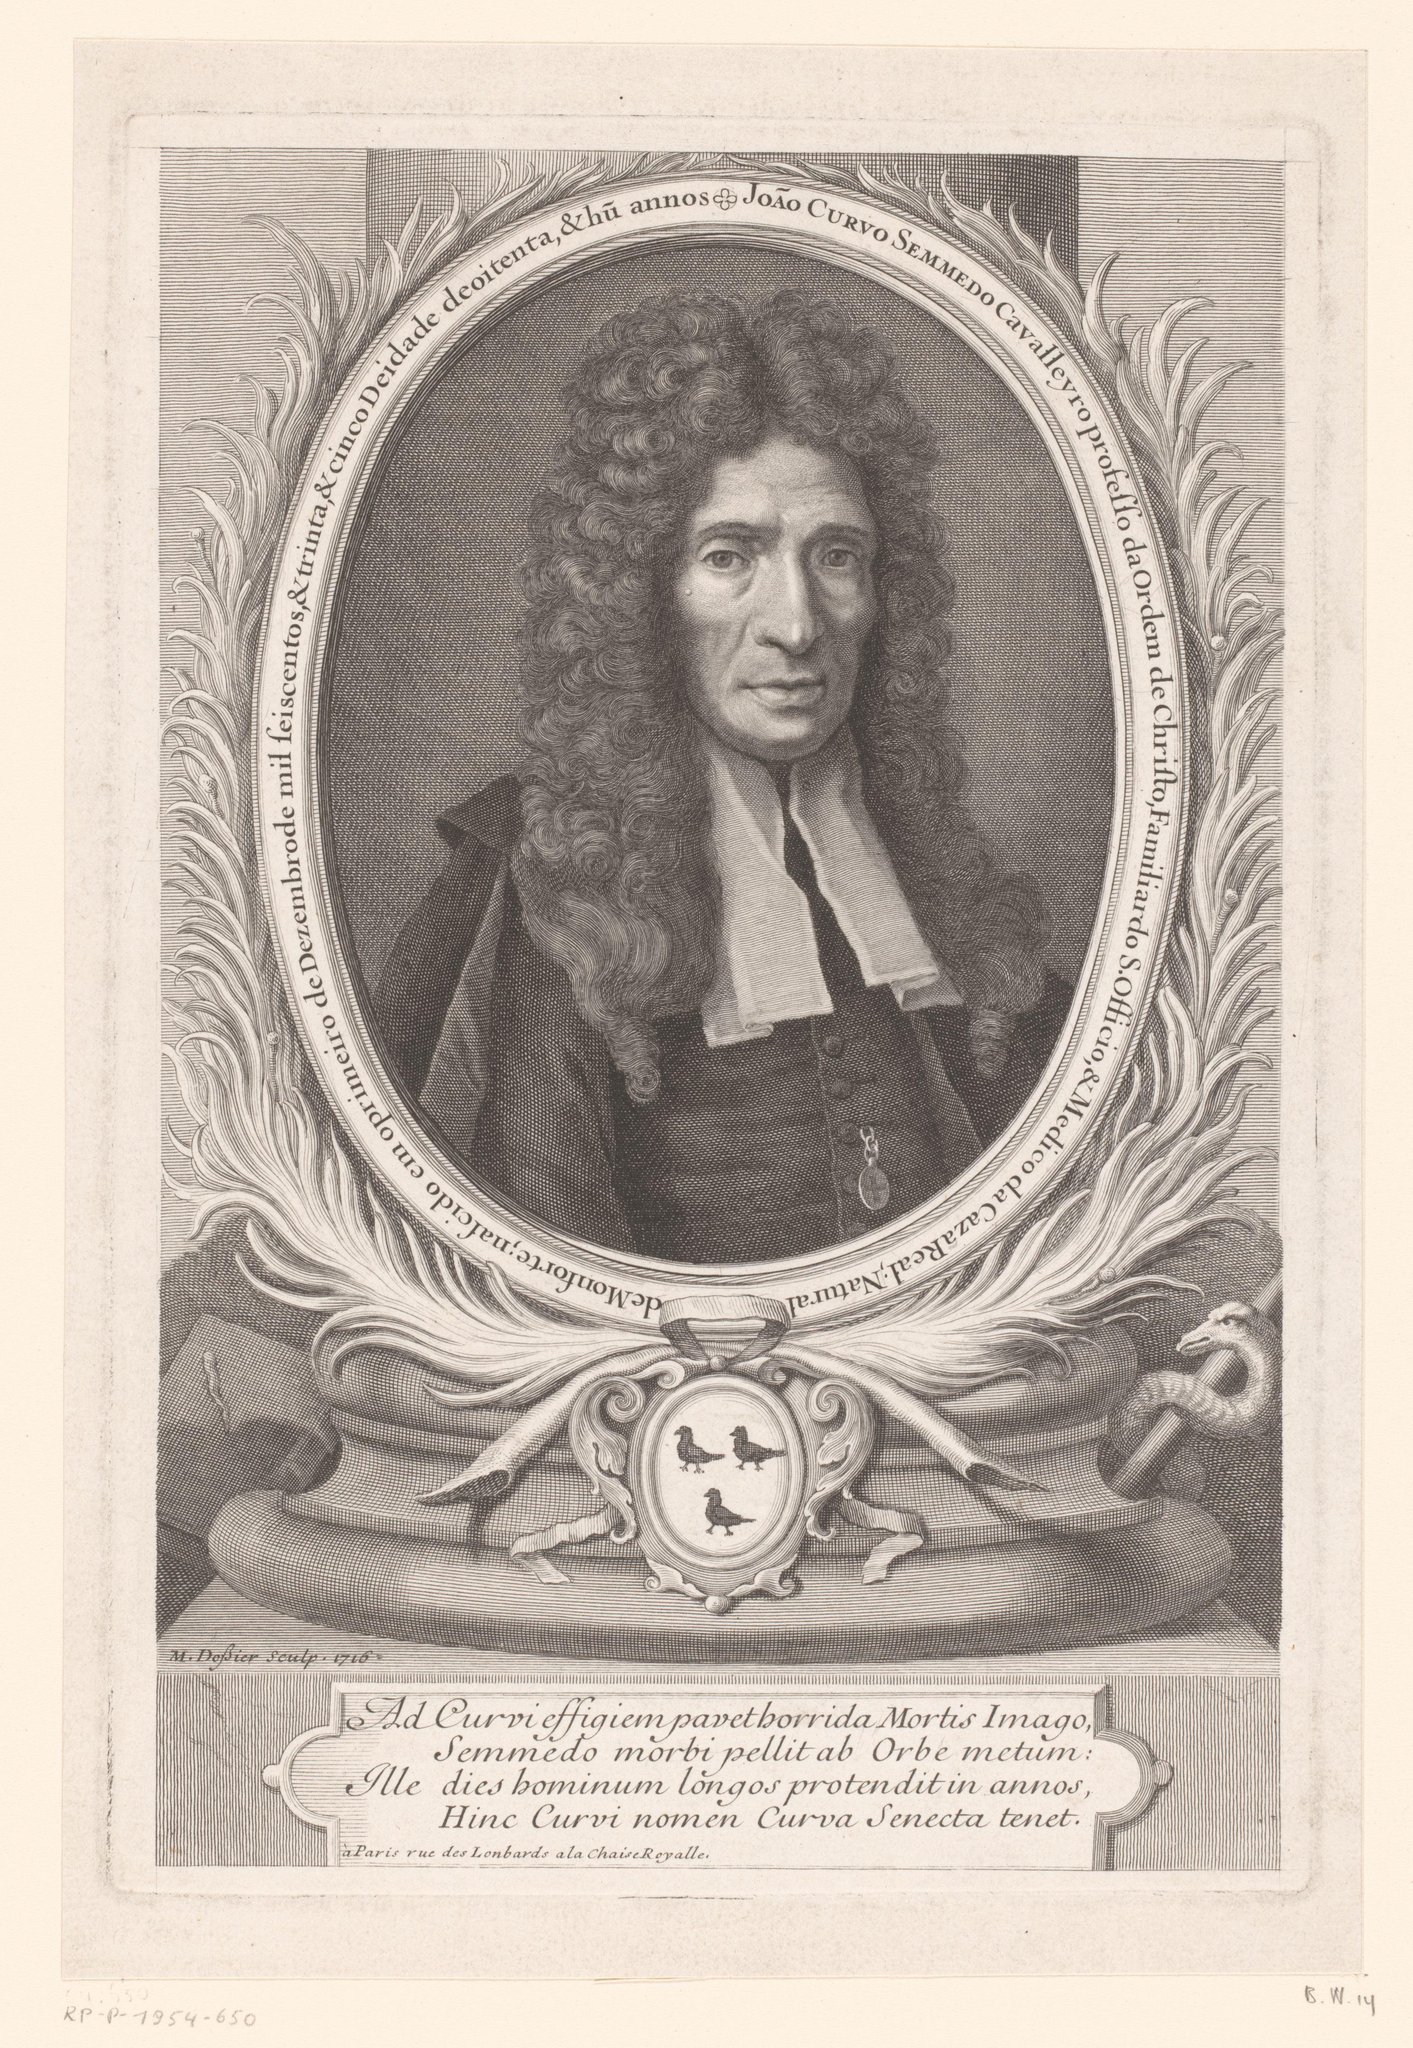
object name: print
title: João Curvo Semmedo Cavalleyro professo da Ordem de Christo (...)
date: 1716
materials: paper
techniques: engraving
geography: paris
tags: ornament ~ medallion, historical persons, physician, doctor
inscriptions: collector's mark: Lugt 2228, collector's mark: Lugt 2760